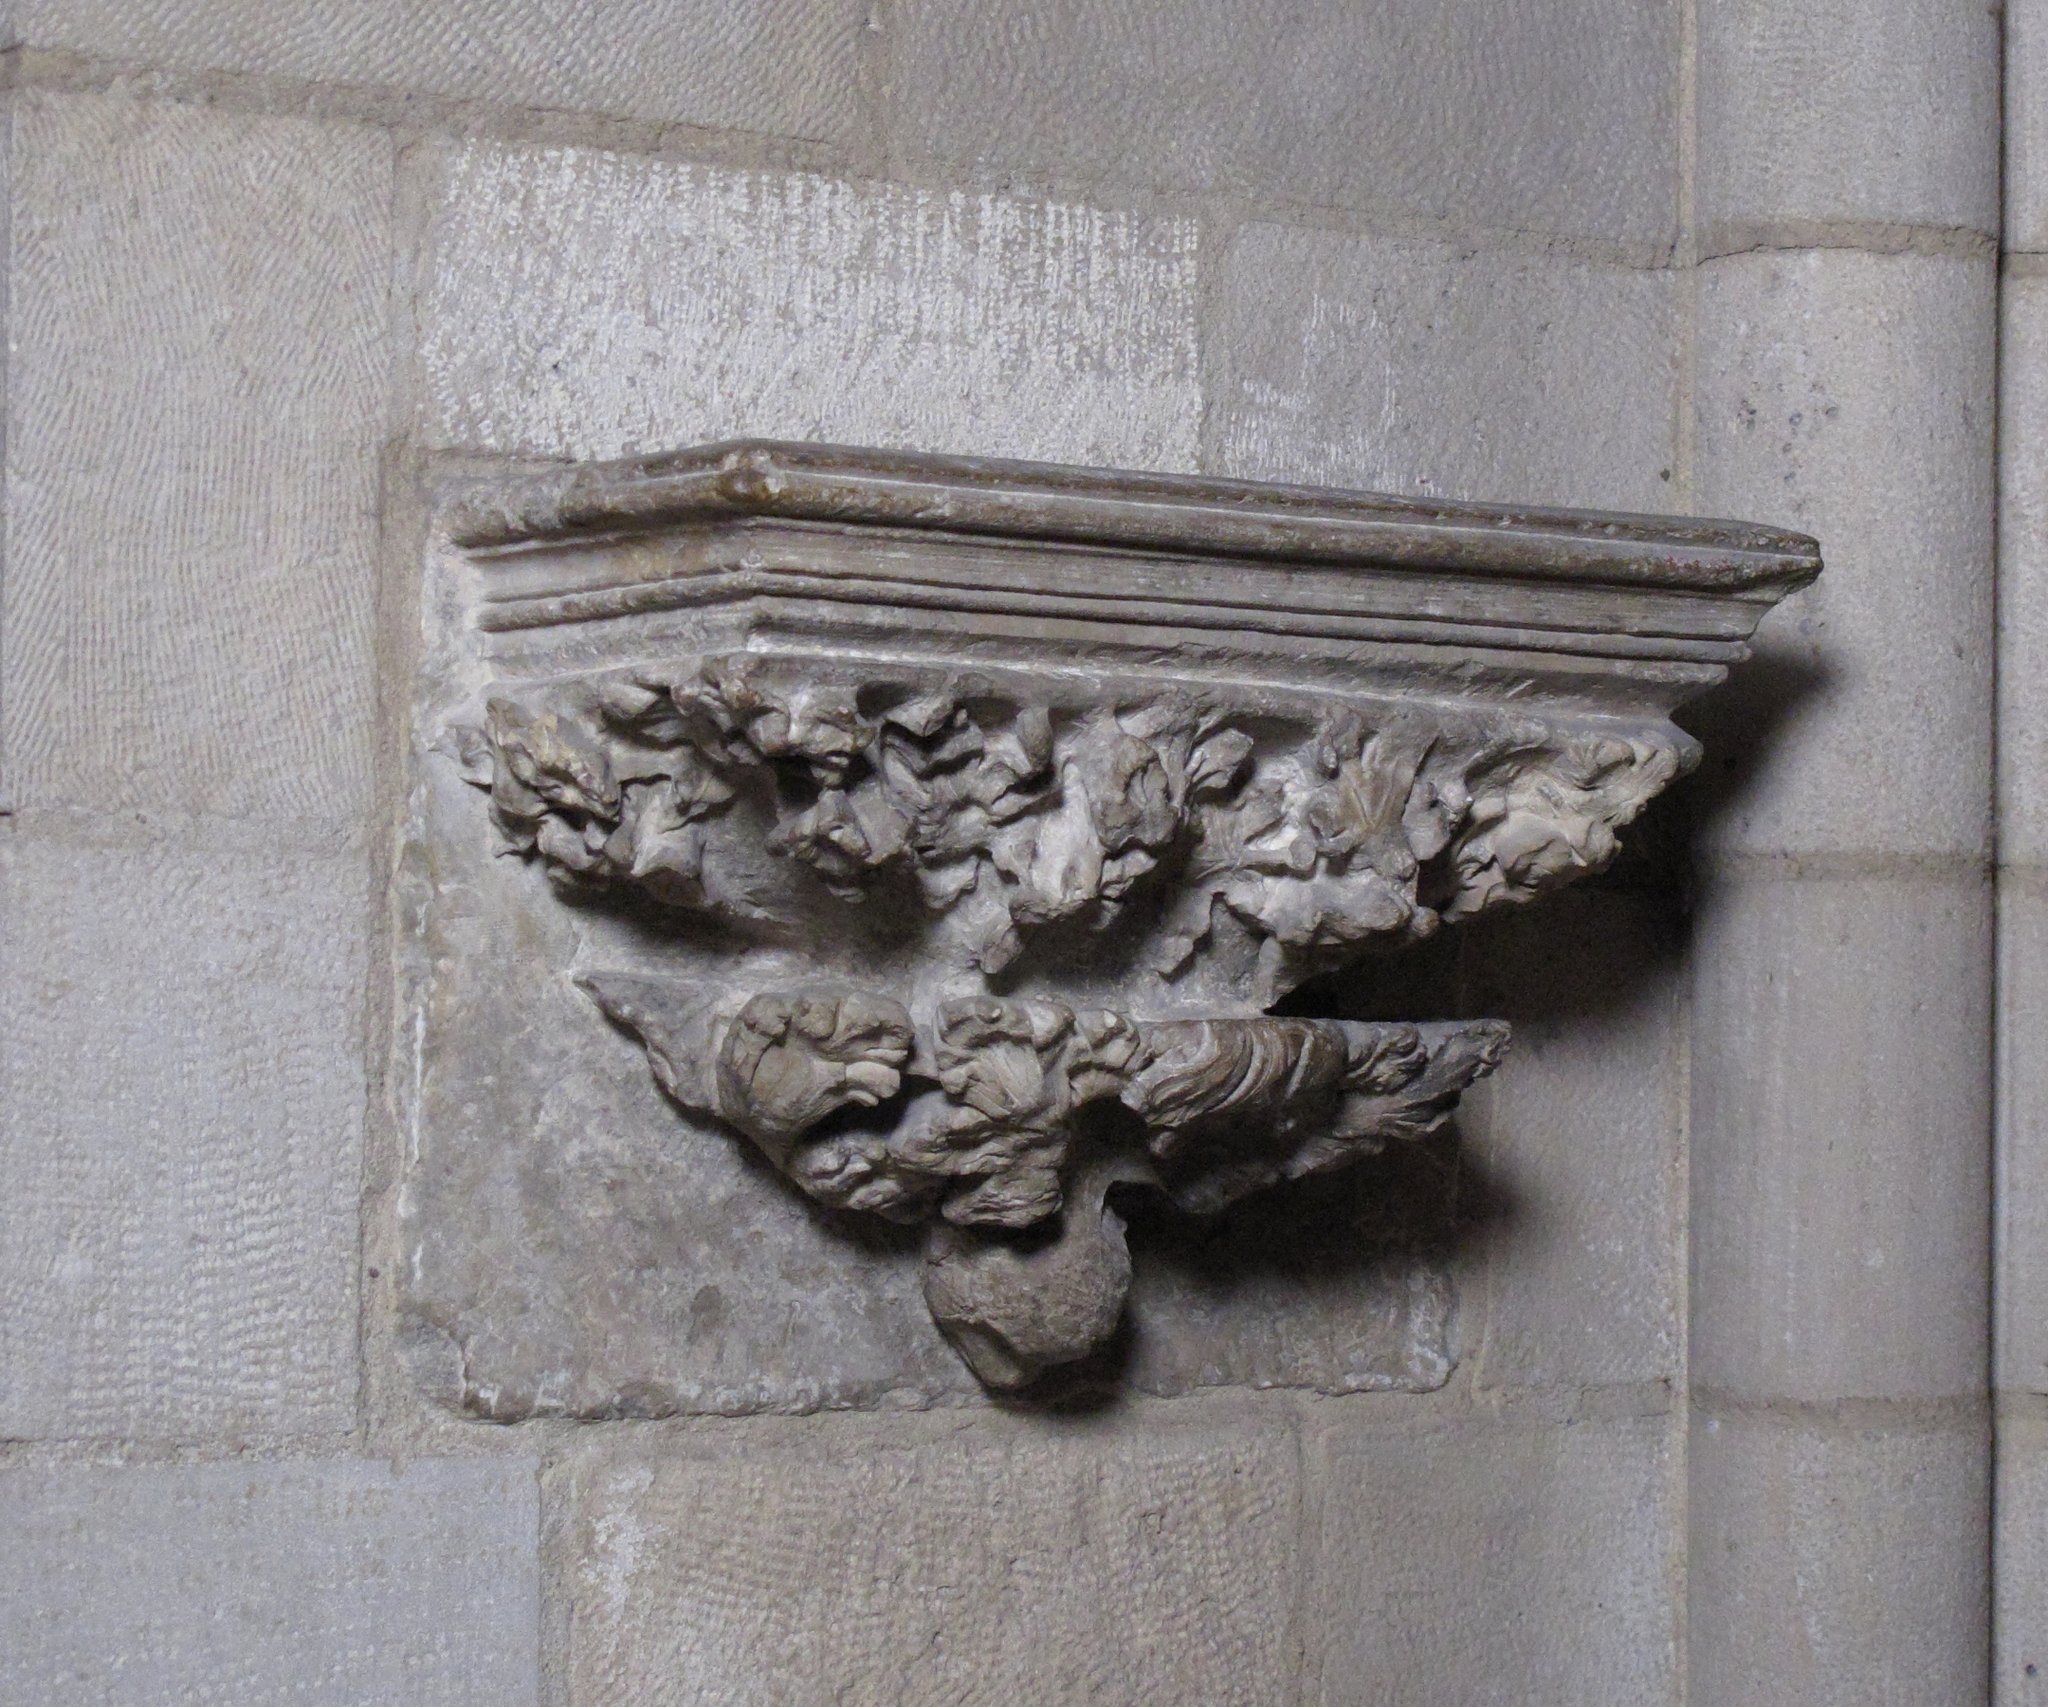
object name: corbel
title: Corbel from the Double Sepulchral Monument of Don Àlvar Rodrigo de Cabrera, Count of Urgell and Viscount of Ager and his wife Cecilia of Foix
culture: catalan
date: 1300-1350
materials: limestone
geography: spain